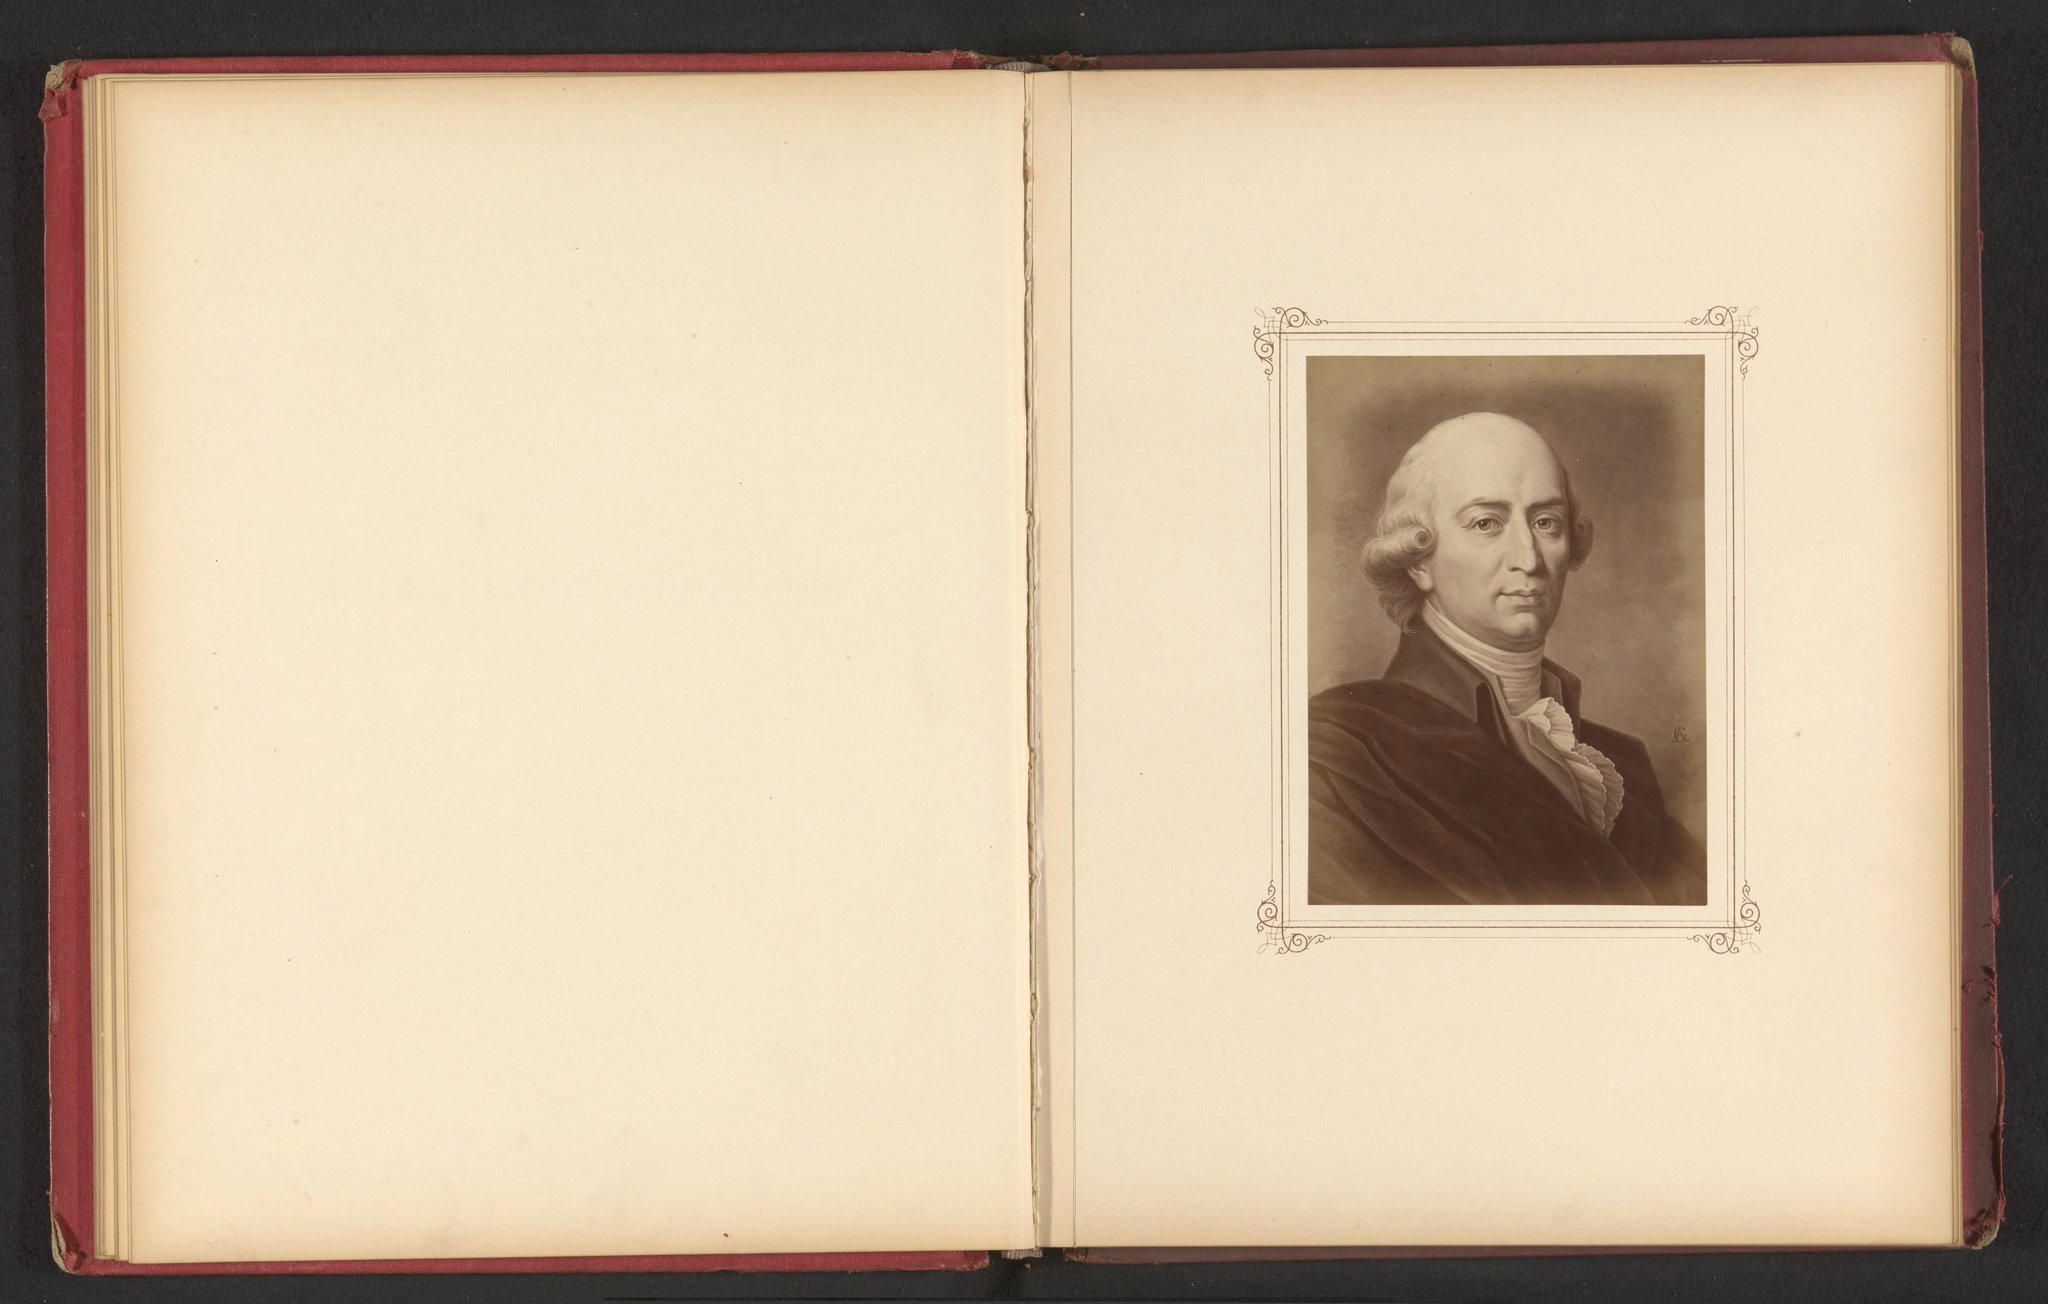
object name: page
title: Fotoreproductie van een portret van Johann Gottfried Herder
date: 1868-1878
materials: photographic support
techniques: albumen print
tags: writer, poet, author